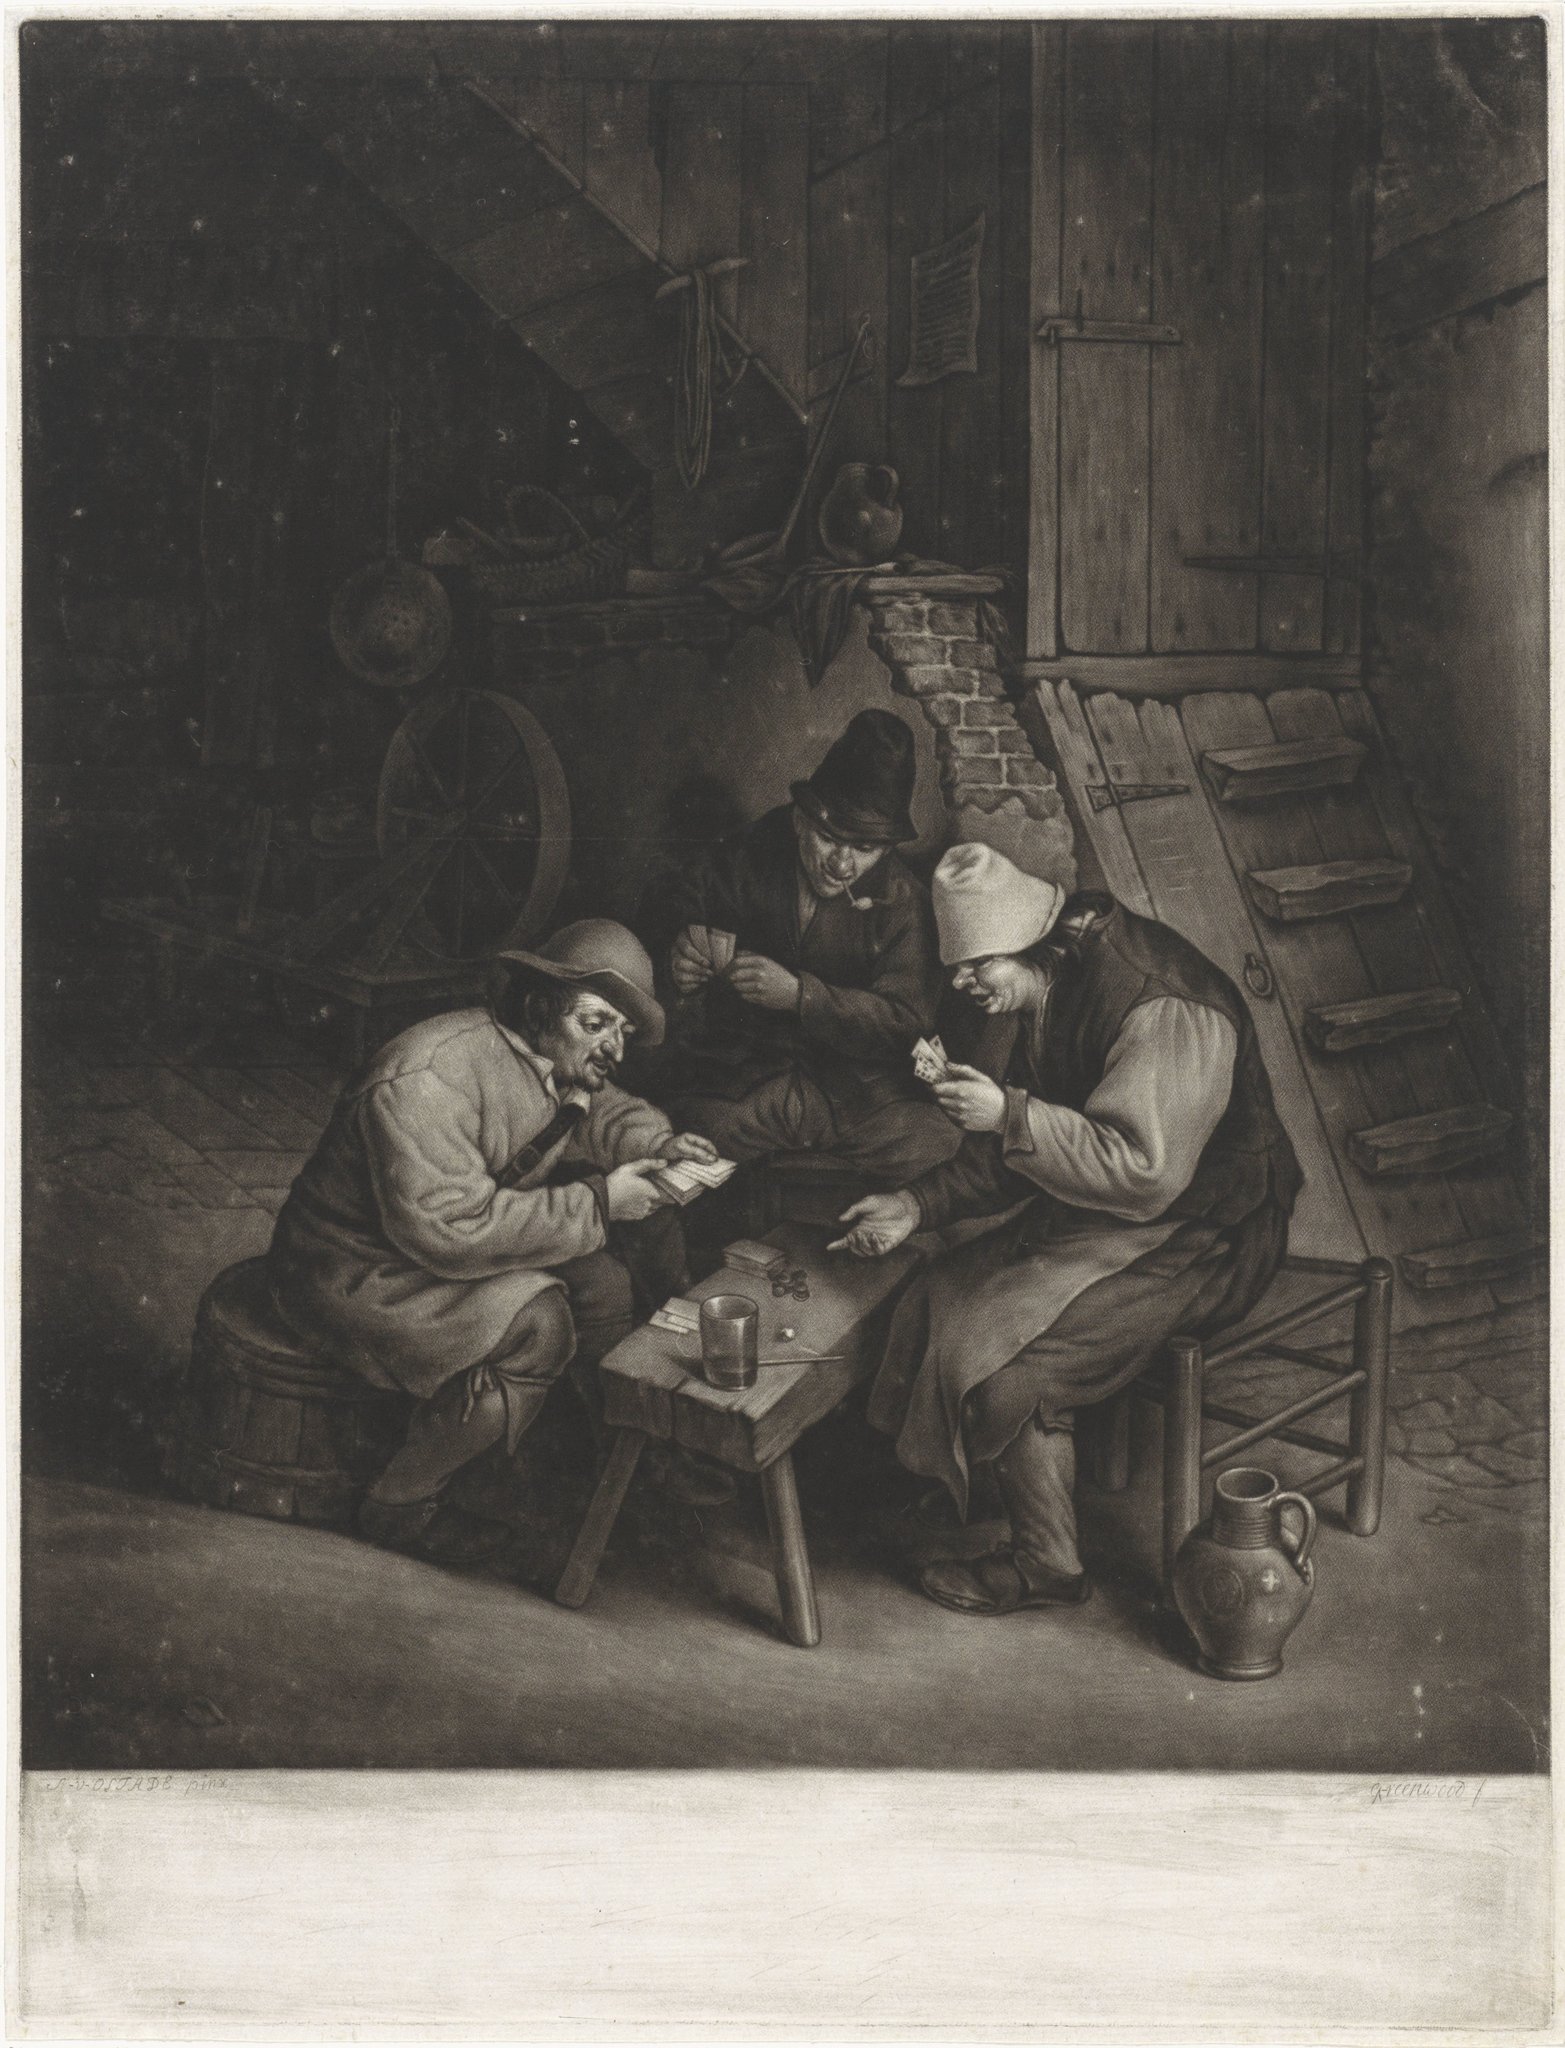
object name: print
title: Herbergscène met drie kaartende boeren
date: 1739-1792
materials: paper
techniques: engraving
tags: inn, coffee-house, public house, etc., pipe ~ tobacco, playing-cards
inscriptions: collector's mark: Lugt 240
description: In een herberg zitten drie boeren aan een tafel te kaarten. Een van hen rookt een pijp.